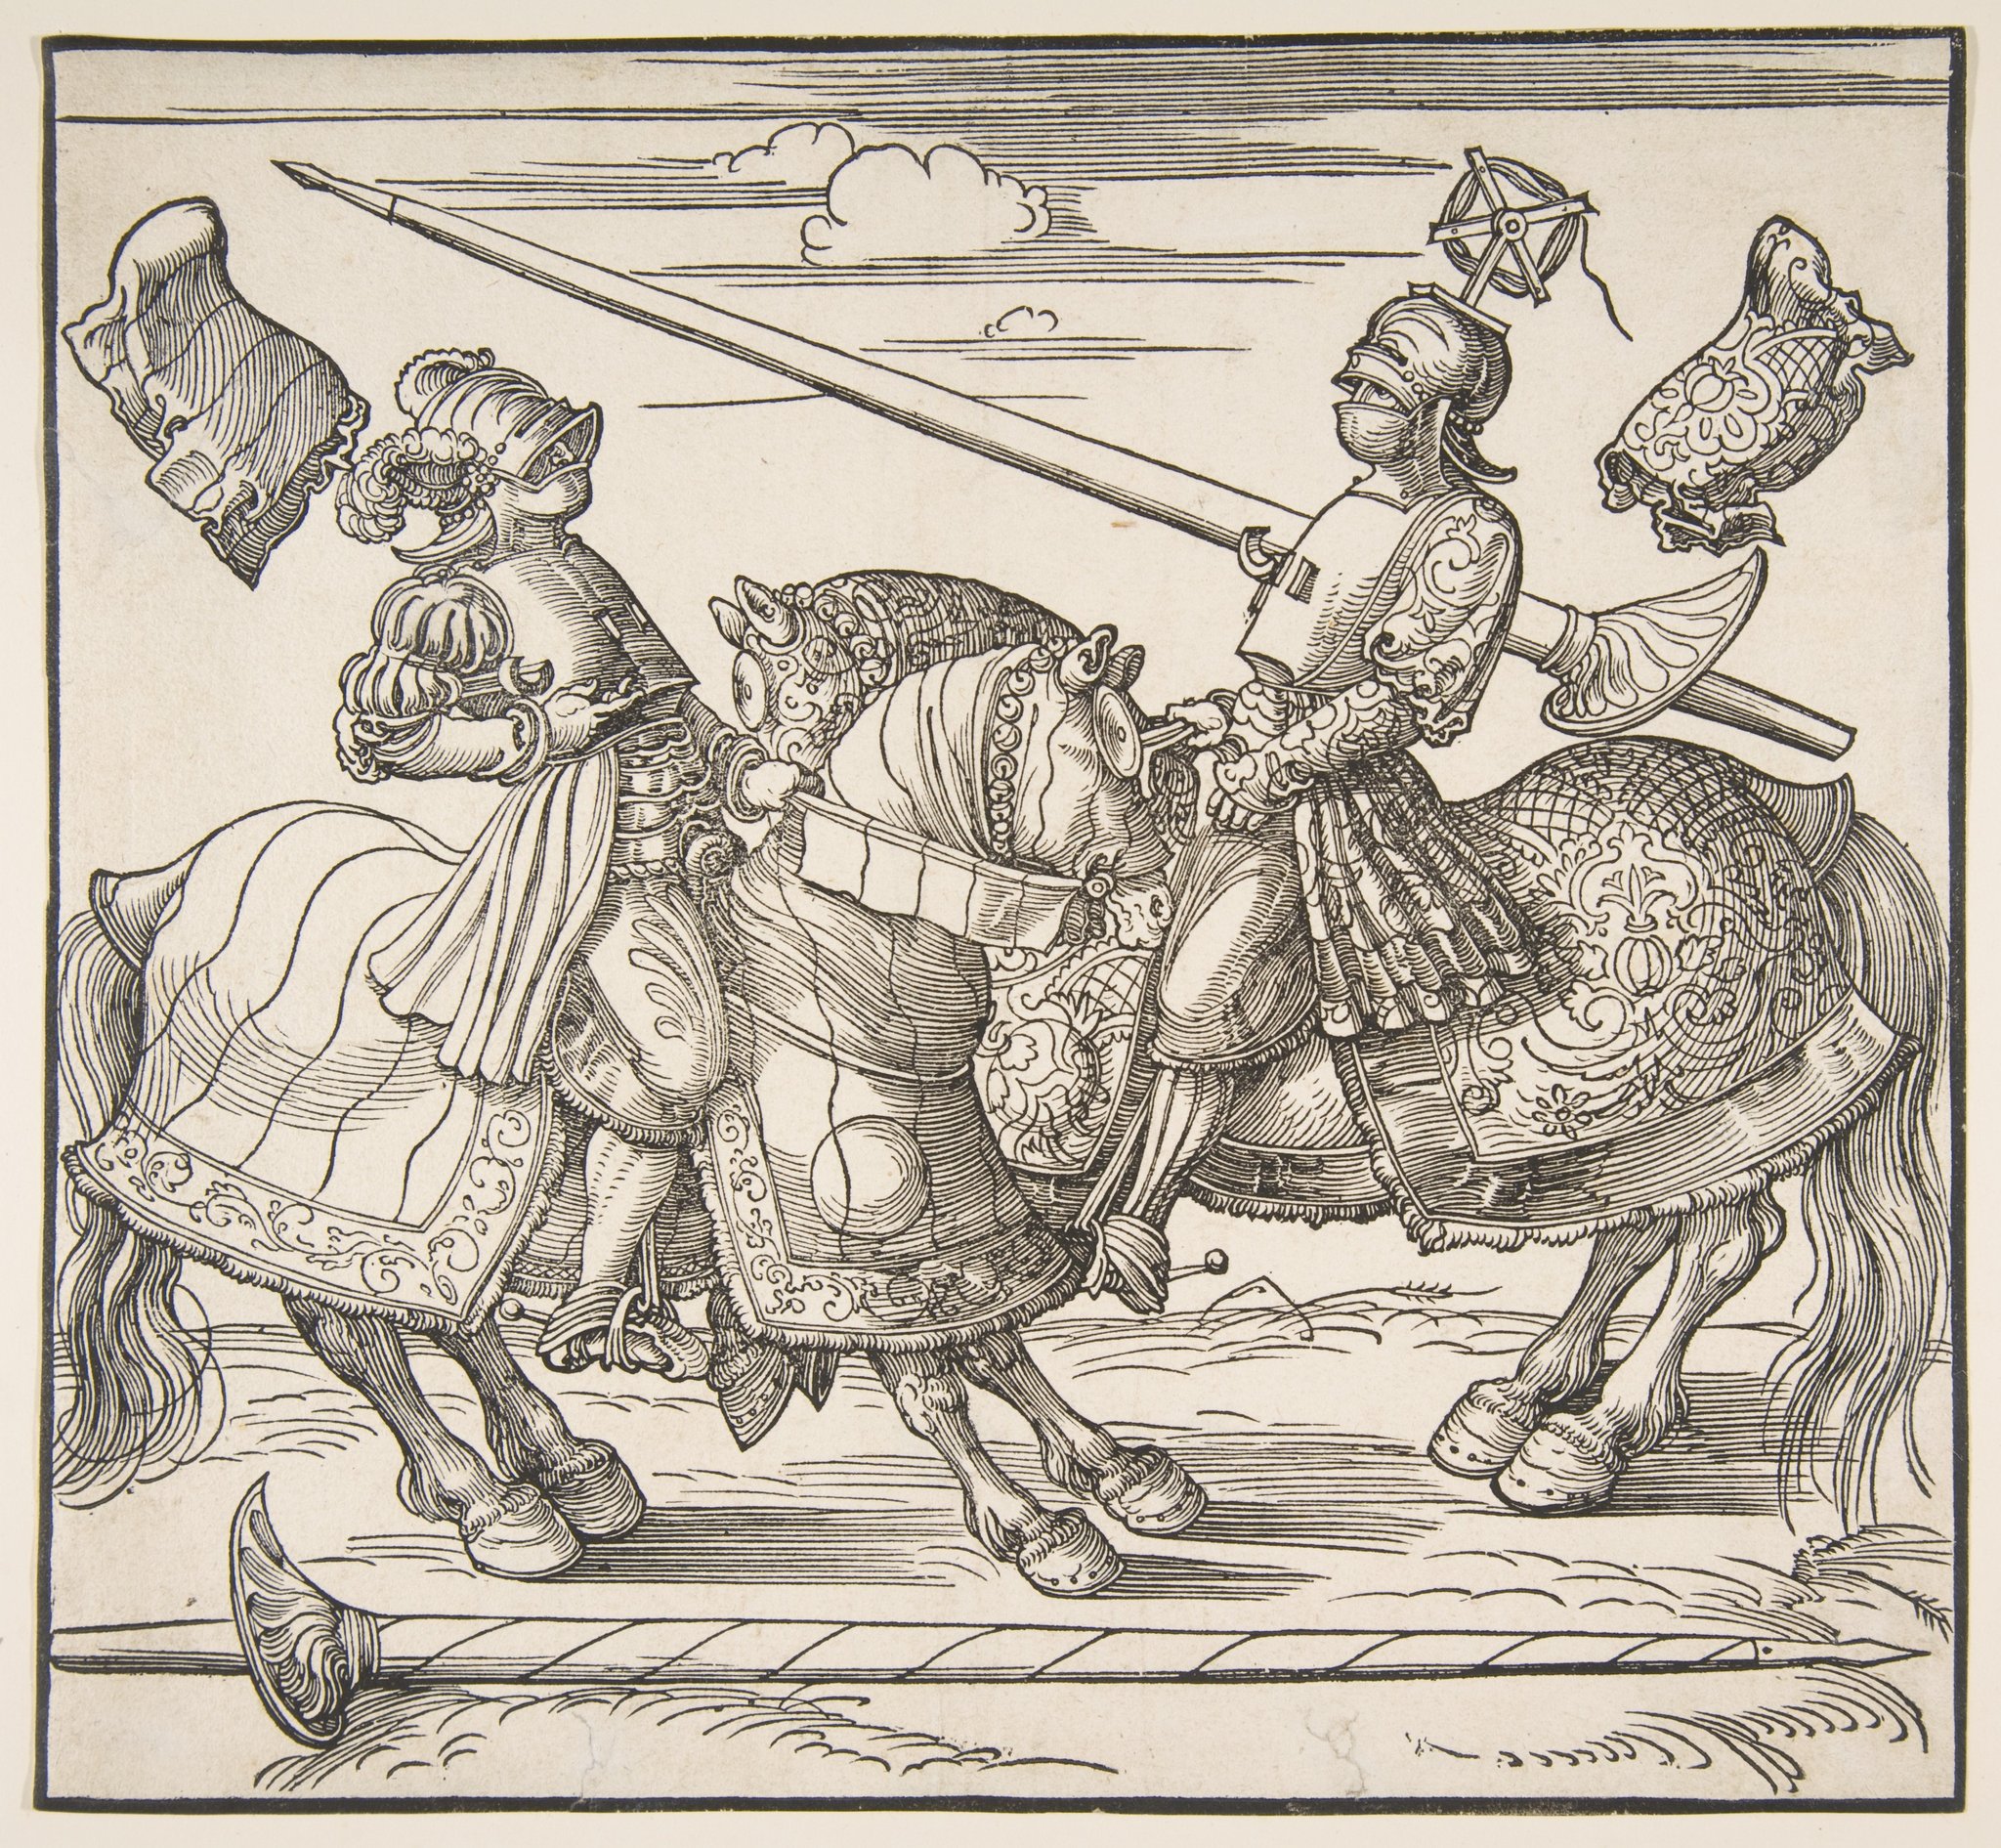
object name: print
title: The Tournament on Horseback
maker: albrecht dürer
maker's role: artist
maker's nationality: german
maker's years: 1471-1528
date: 1517-1518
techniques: woodcut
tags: human figures,sports,horses